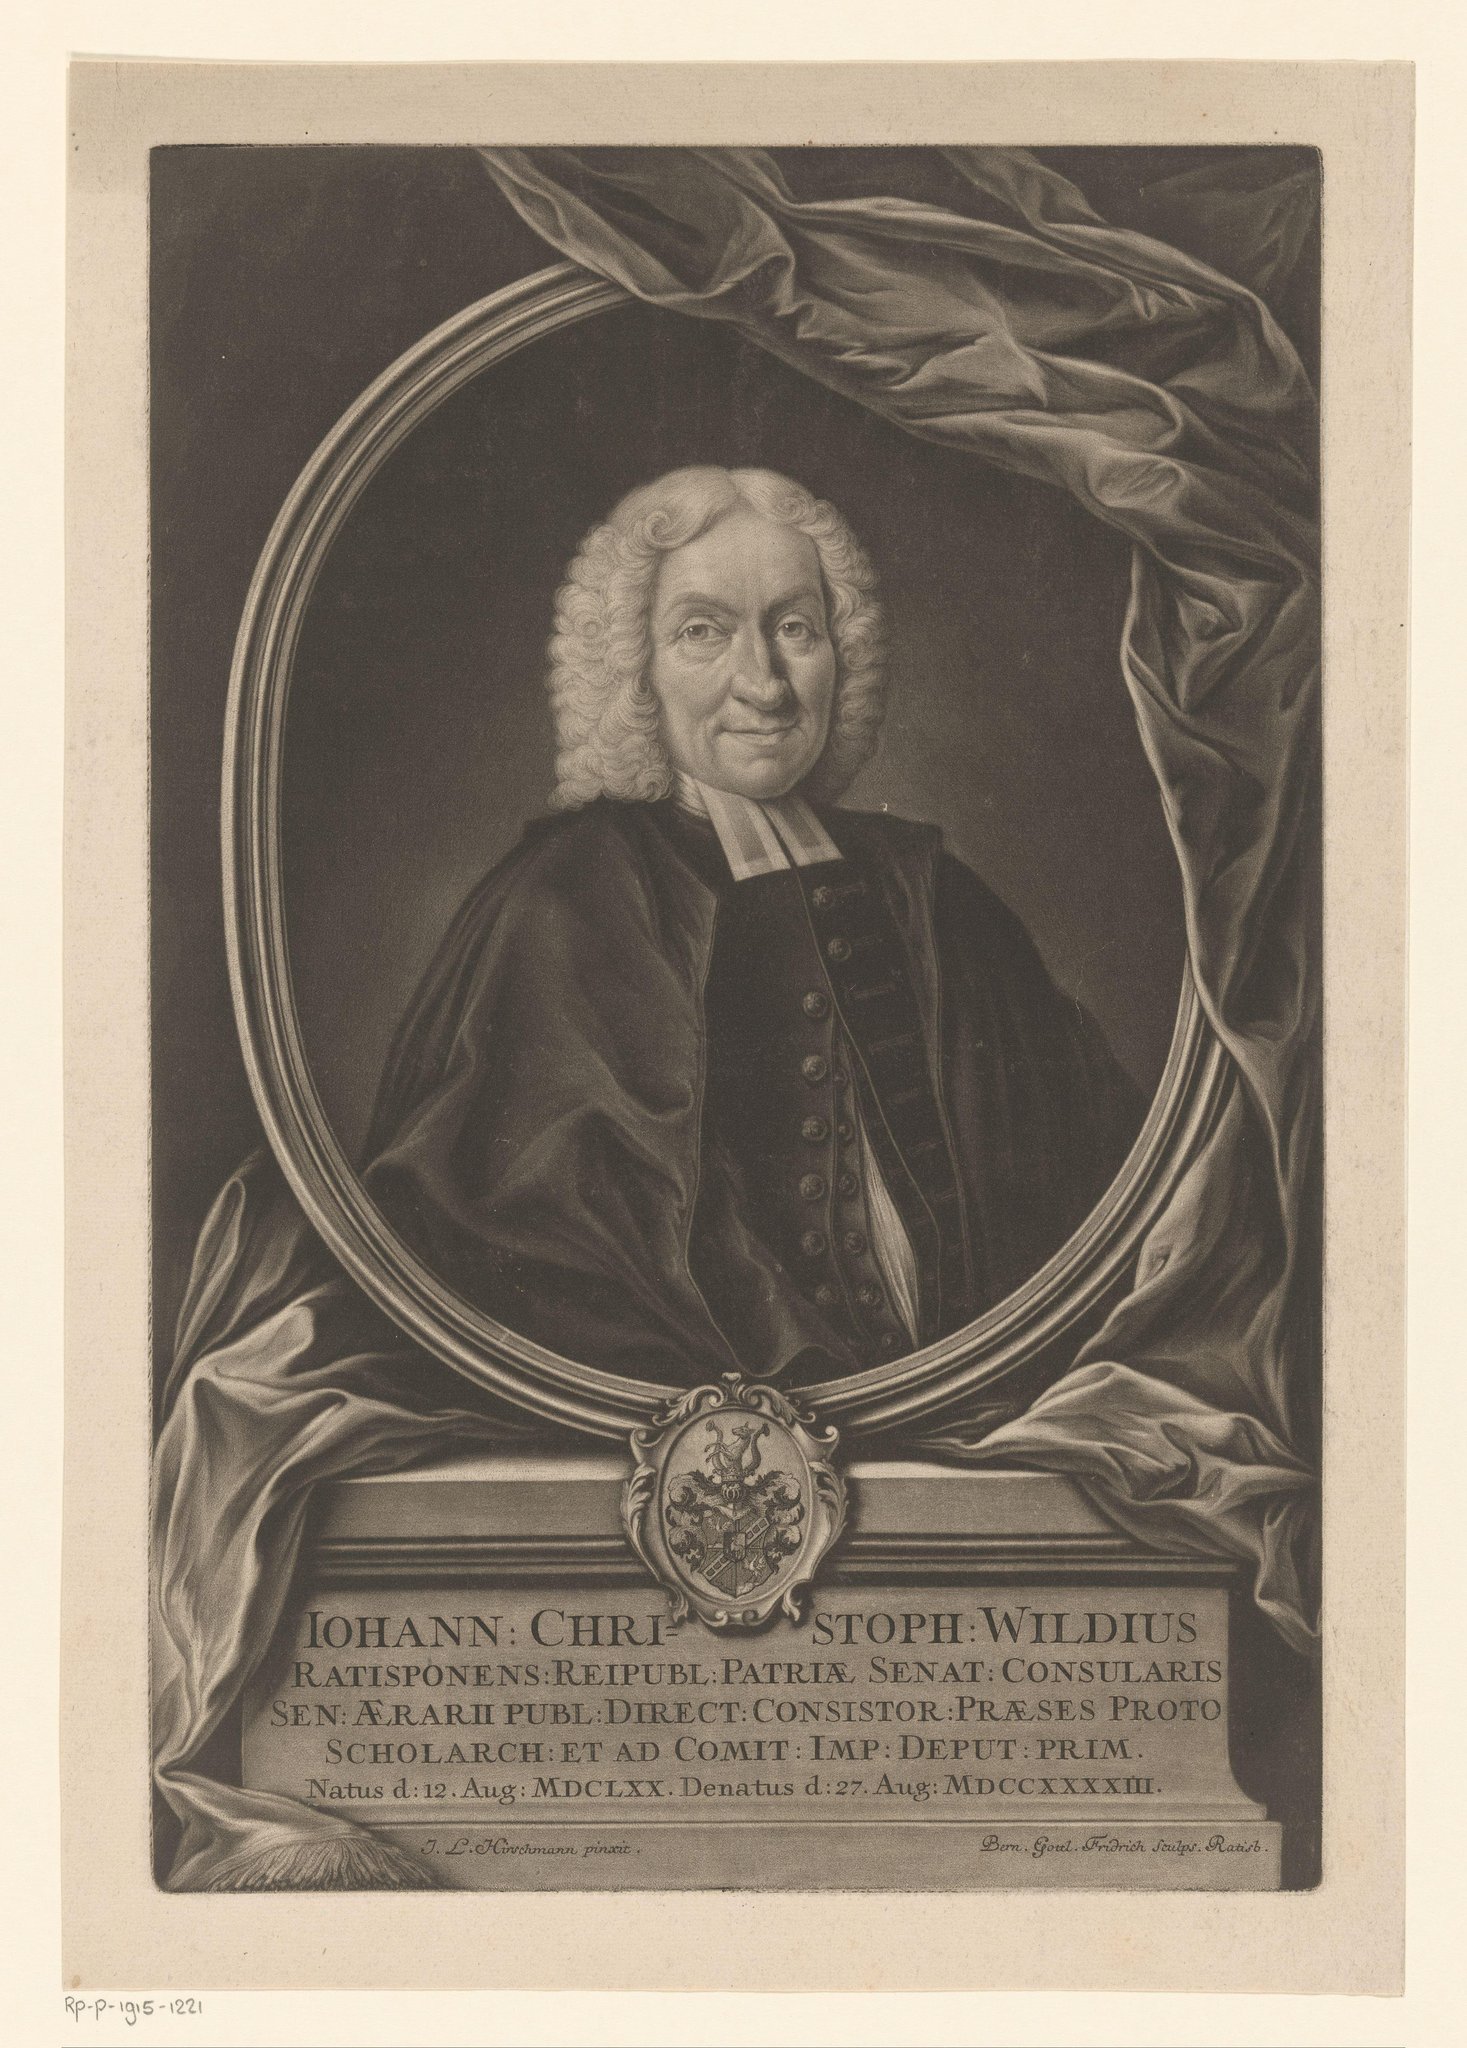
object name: print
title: Portret van Johann Christoph Wild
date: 1743-1756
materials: paper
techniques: mezzotint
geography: regensburg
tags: official, historical persons, armorial bearing, heraldry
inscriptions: collector's mark: Lugt 2228